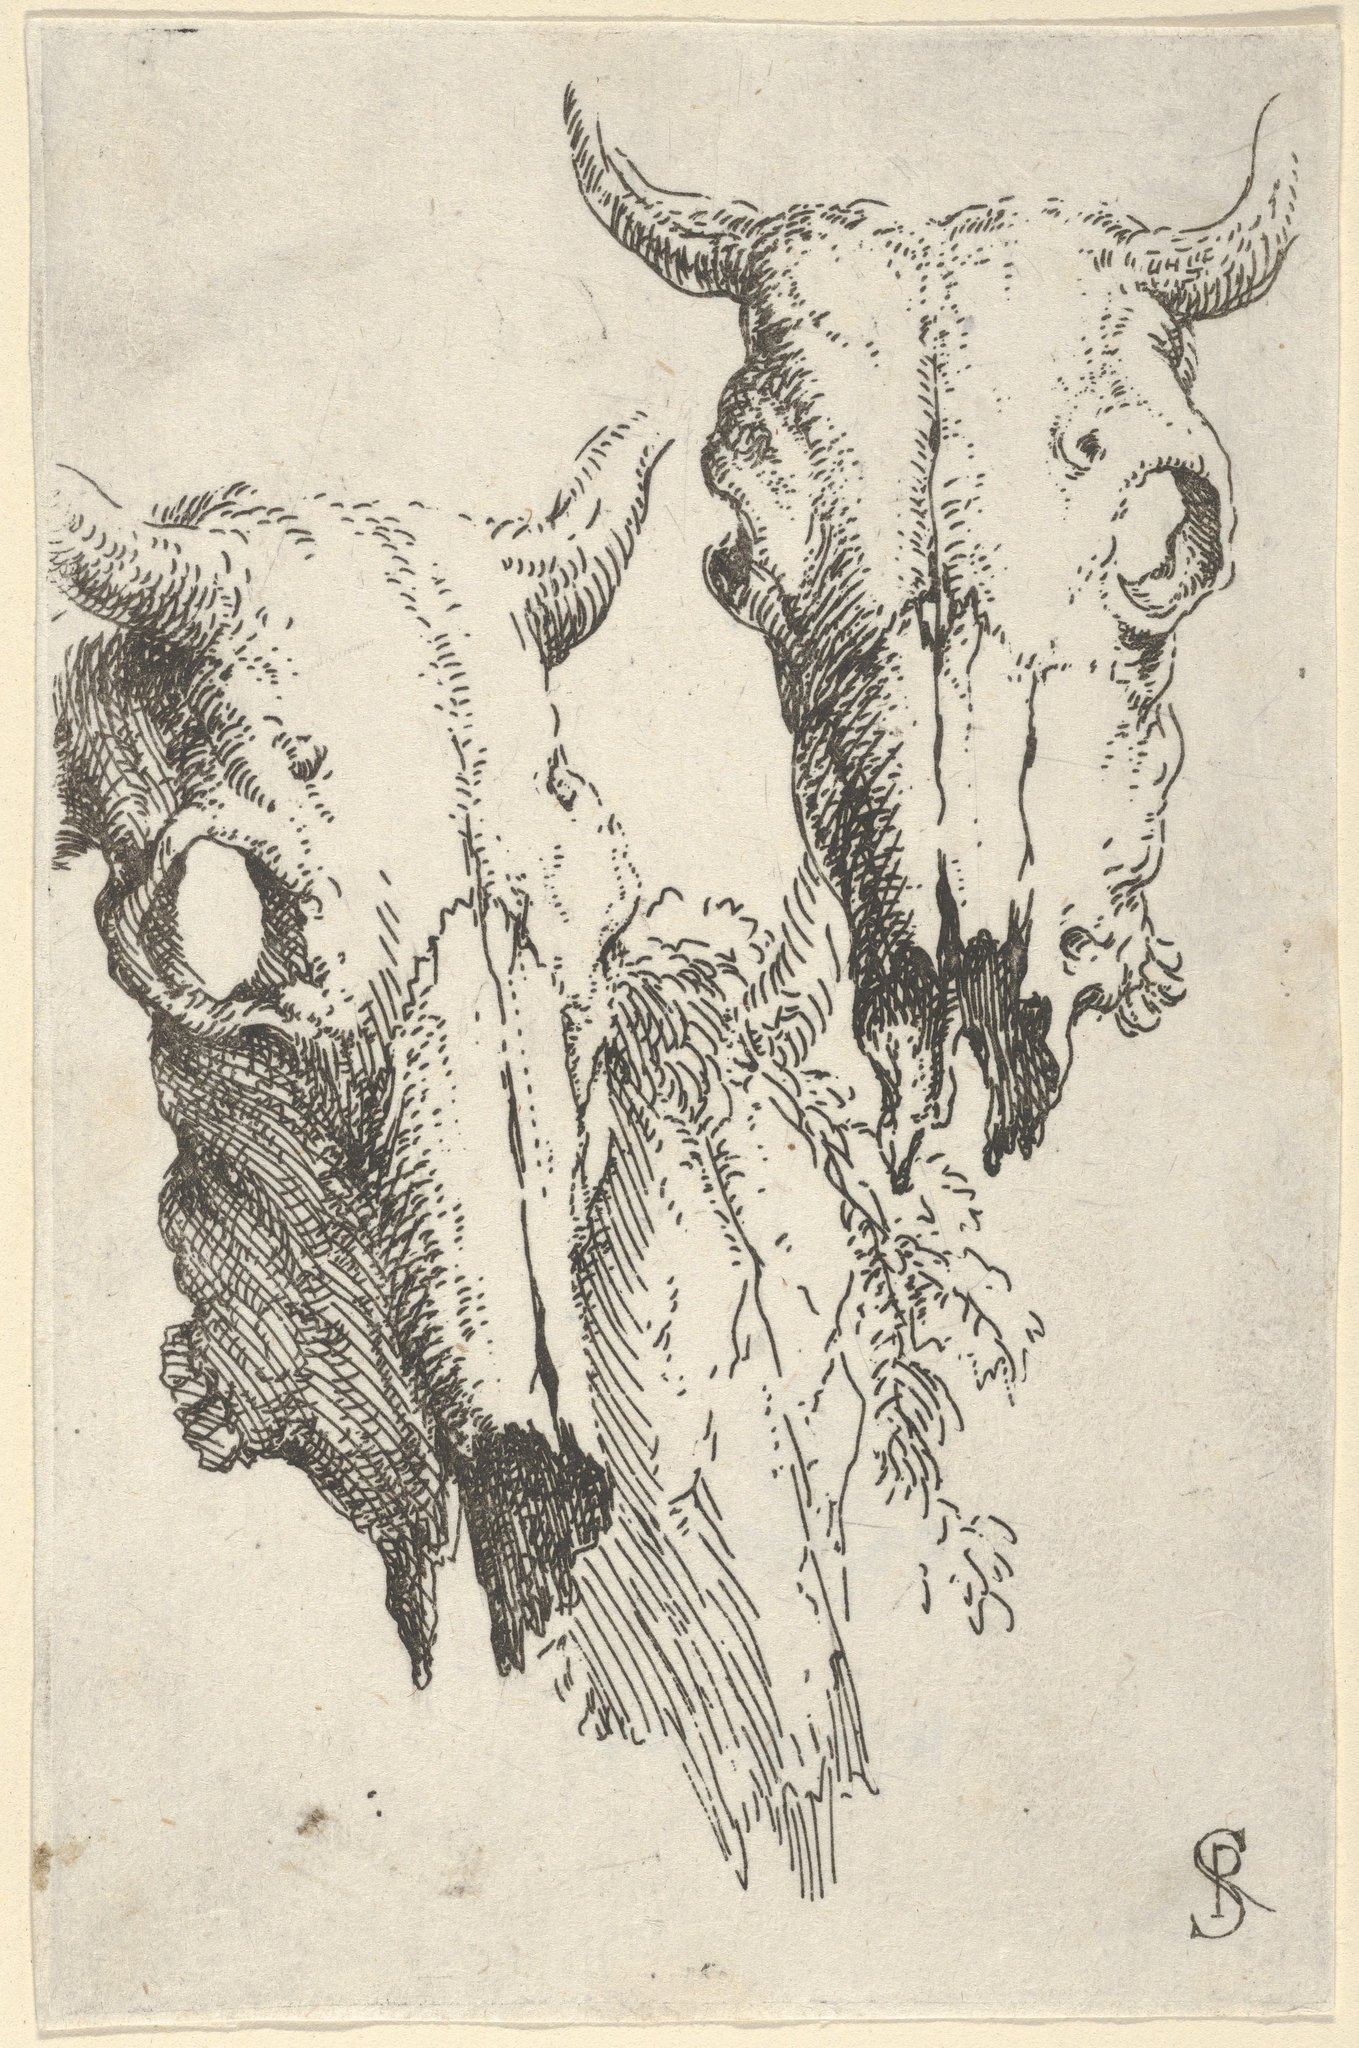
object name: print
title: Two ox skulls and a portion of a third, study for "Democritus in Meditation"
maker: salvator rosa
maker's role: artist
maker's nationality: italian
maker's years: 1615-1673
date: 1662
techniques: etching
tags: animals